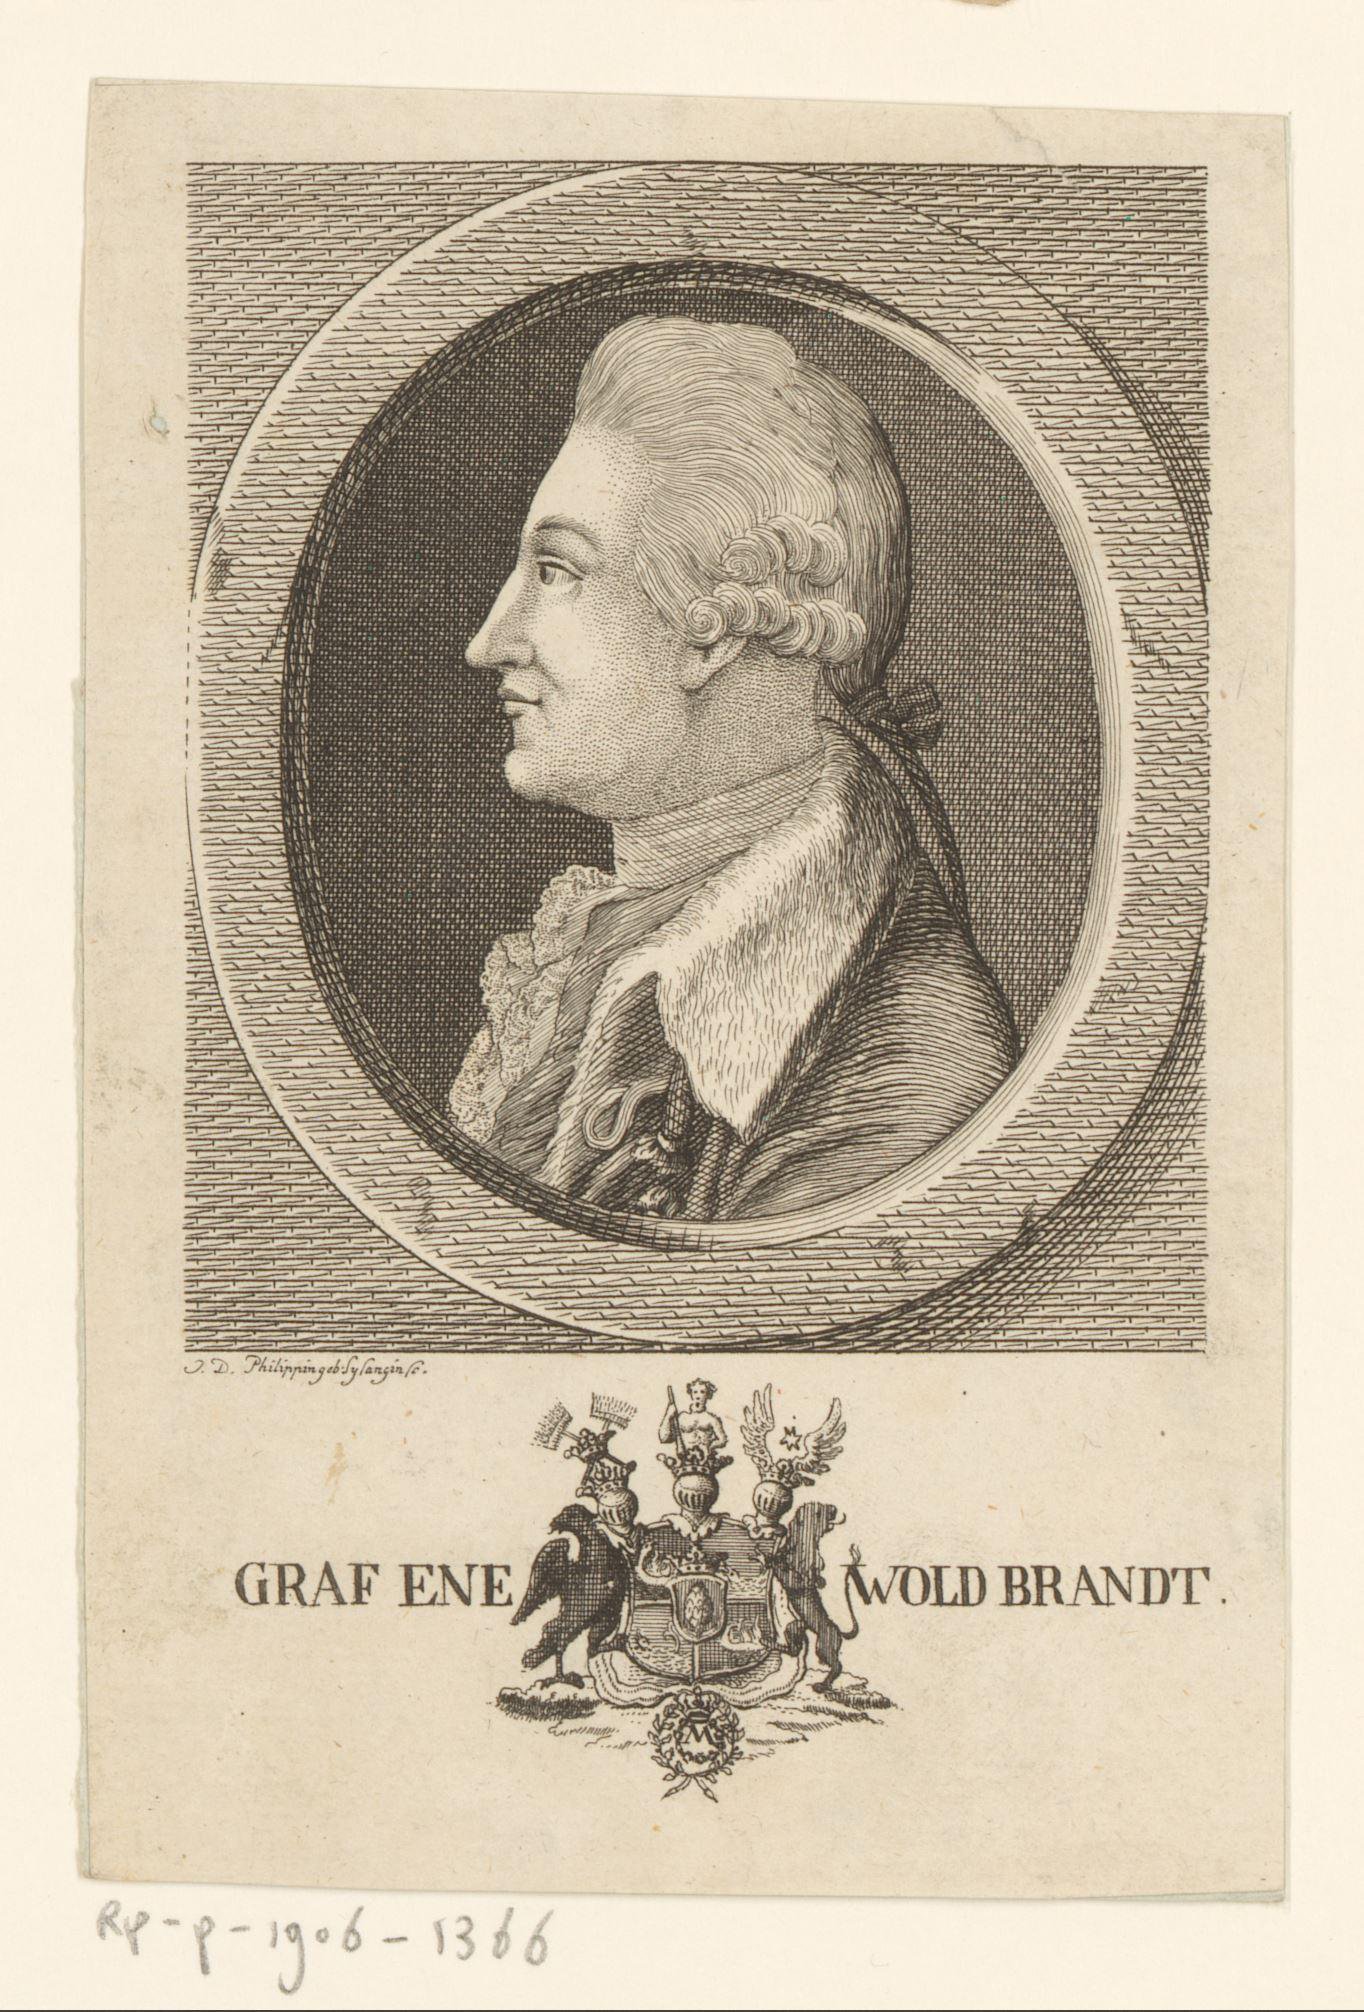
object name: print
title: Portret van Enewold Brandt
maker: johanna dorothea sysang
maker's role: print maker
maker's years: 1729-1791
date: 1752-1791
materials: paper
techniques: engraving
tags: historical persons, armorial bearing, heraldry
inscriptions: collector's mark: Lugt 2228